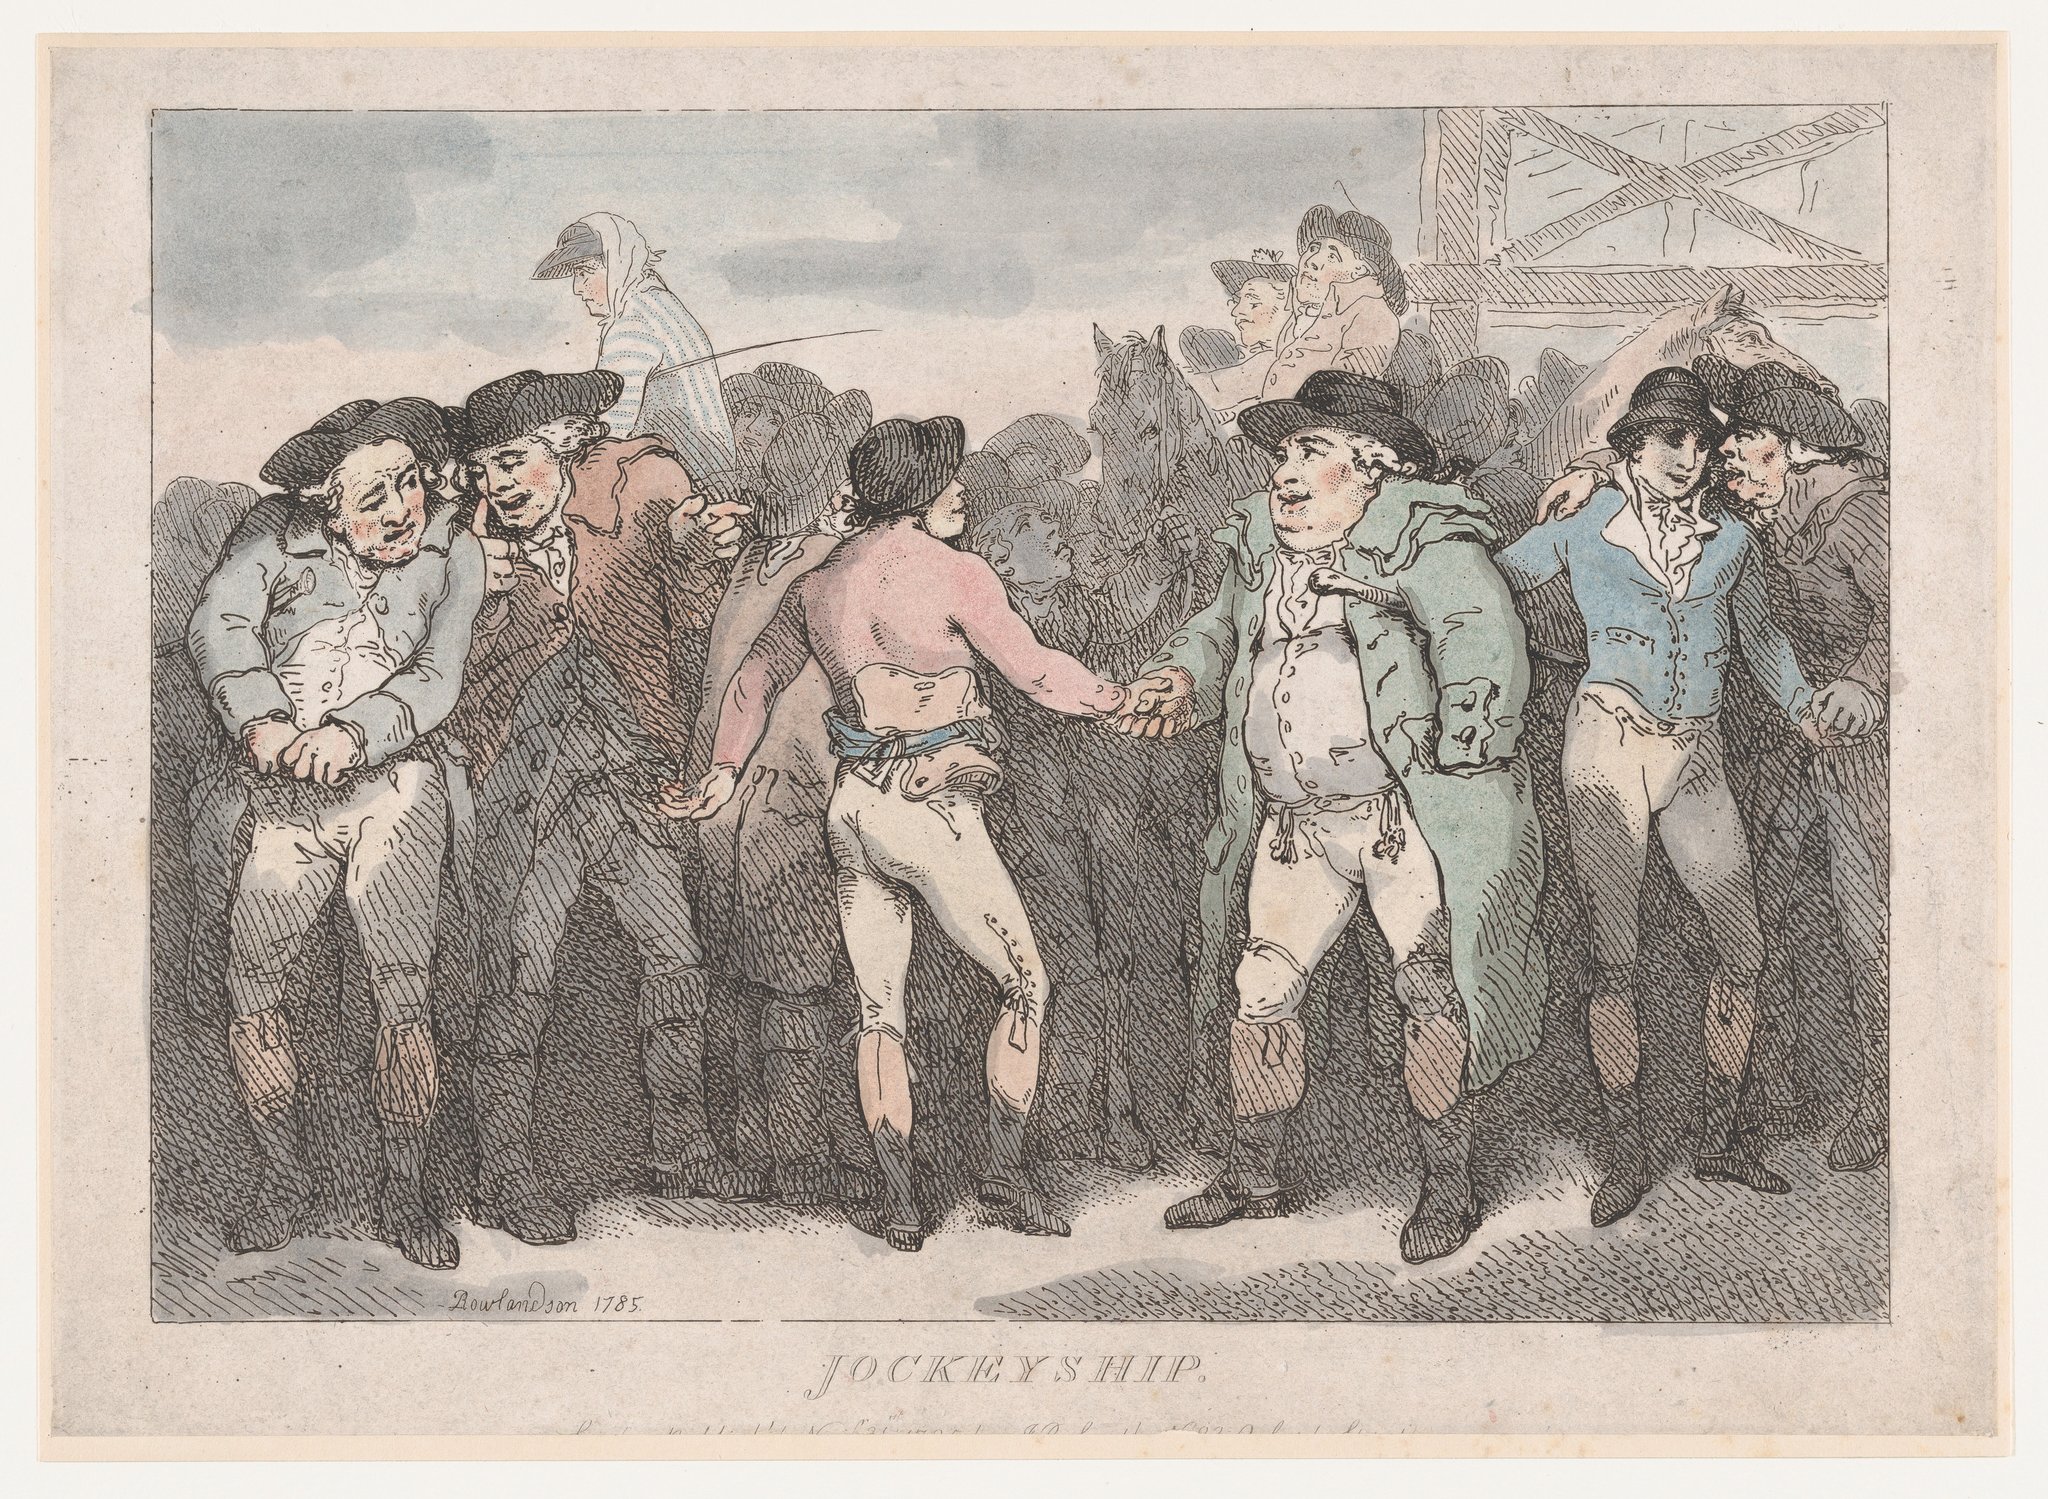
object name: print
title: Jockeyship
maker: thomas rowlandson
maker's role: artist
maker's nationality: british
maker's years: 1757-1827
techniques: etching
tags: men,horses,jockeys